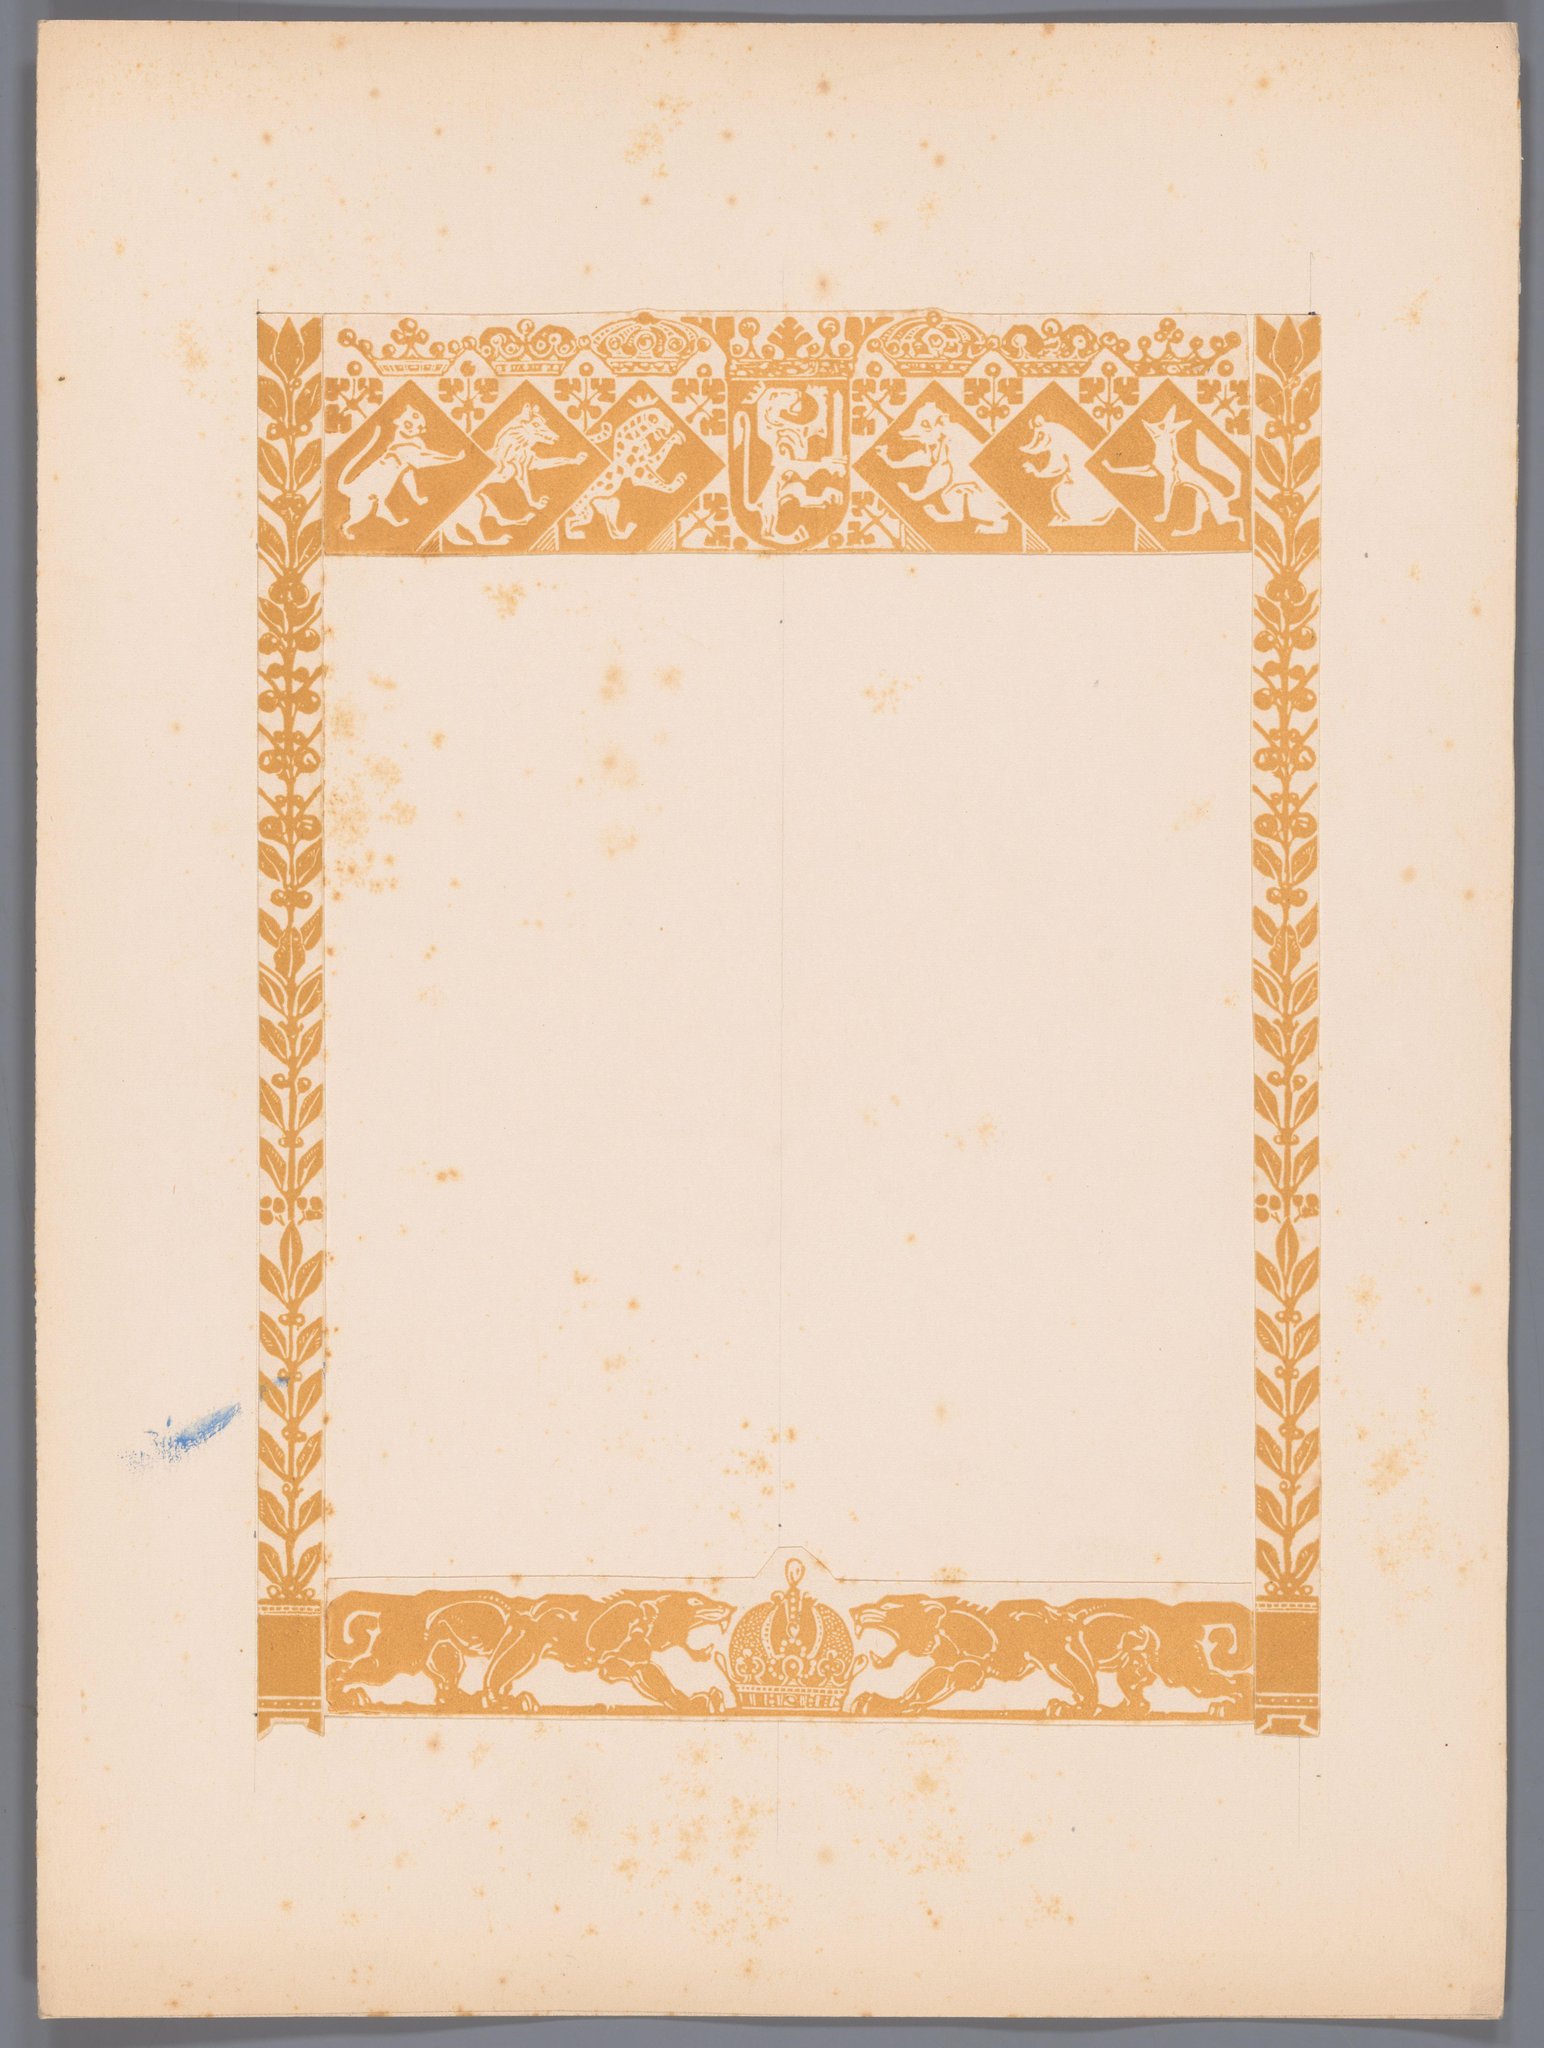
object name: boekillustratie ontwerp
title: Proefdruk voor pagina uit Reinaert de Vos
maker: bernard willem wierink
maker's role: draughtsman, print maker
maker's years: 1856-1939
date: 1910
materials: paper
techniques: relief print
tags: fable of reynard the fox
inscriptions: collector's mark: Lugt 2228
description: Ontwerp voor: Streuvels, Stijn (Frank Lateur). Reinaert de Vos naar verschillende uitgaven van het middeleeuwsche epos. Amsterdam: L.J. Veen, 1910. Deze prent is vermoedelijk een plaatsnede, ook al wordt in de literatuur veelal gesproken over een houtsnede. Voor zover Wierink zijn prenten in hoogdruk zelf nader heeft omschreven, heeft hij altijd de term 'plaatsnede' gebruikt.